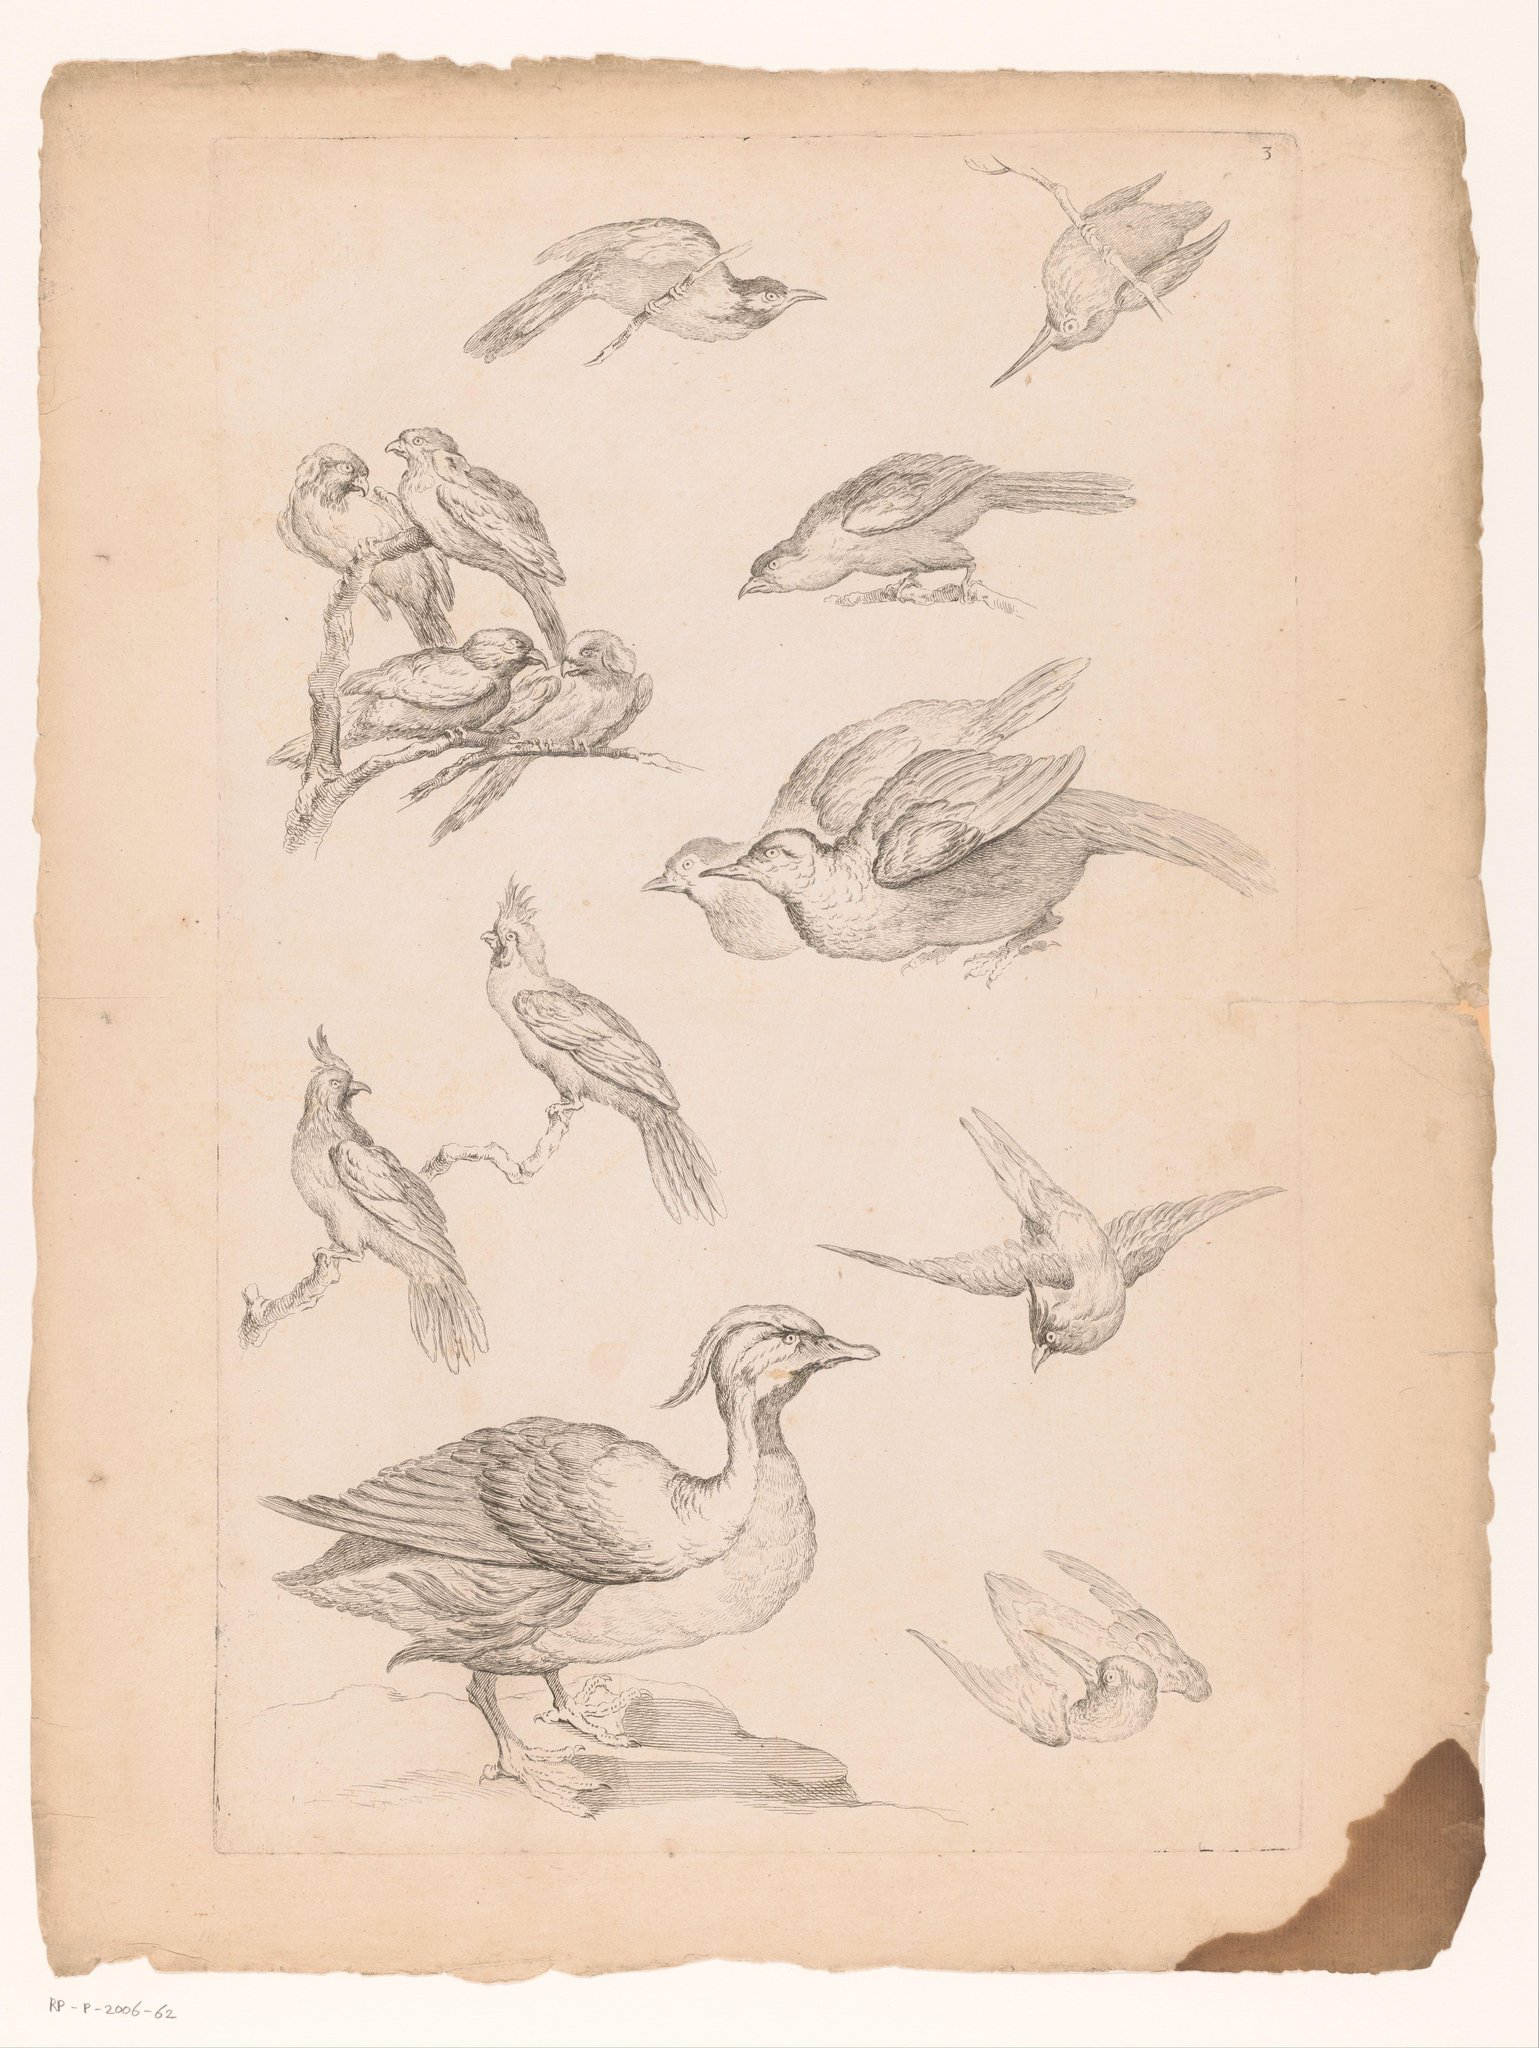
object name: ornament print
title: Veertien Chinese vogels, waaronder eenden en ijsvogels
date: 1742-1750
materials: paper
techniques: etching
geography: france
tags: birds, water-birds: duck, other birds: kingfisher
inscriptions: collector's mark: Lugt 2228, collector's mark: Lugt 2760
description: Maakt deel uit van een vijftiendelige serie met prenten van vogels uit China.